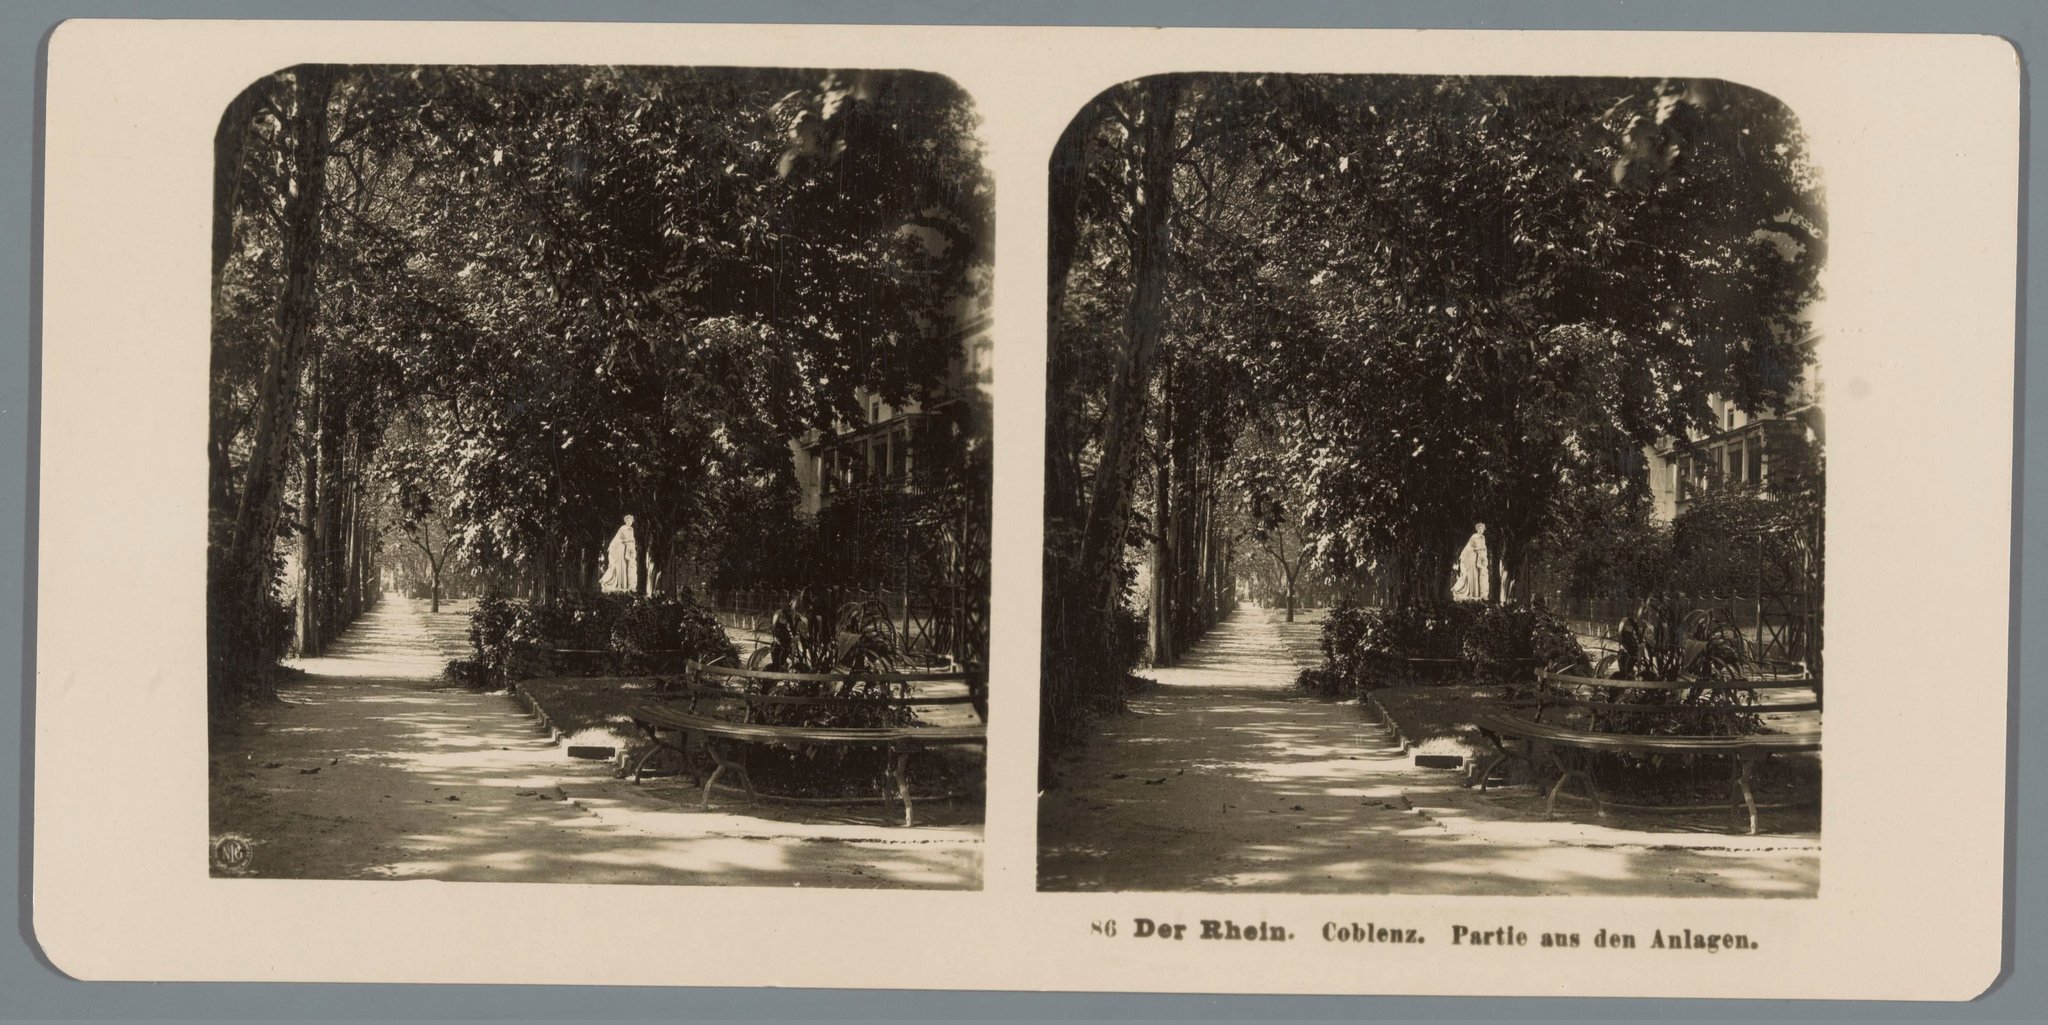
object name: stereograph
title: Plantsoen te Koblenz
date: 1900-1910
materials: cardboard, photographic support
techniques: gelatin silver print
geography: koblenz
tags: plantation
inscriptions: number: ‘86’, inscription: ‘NPG’